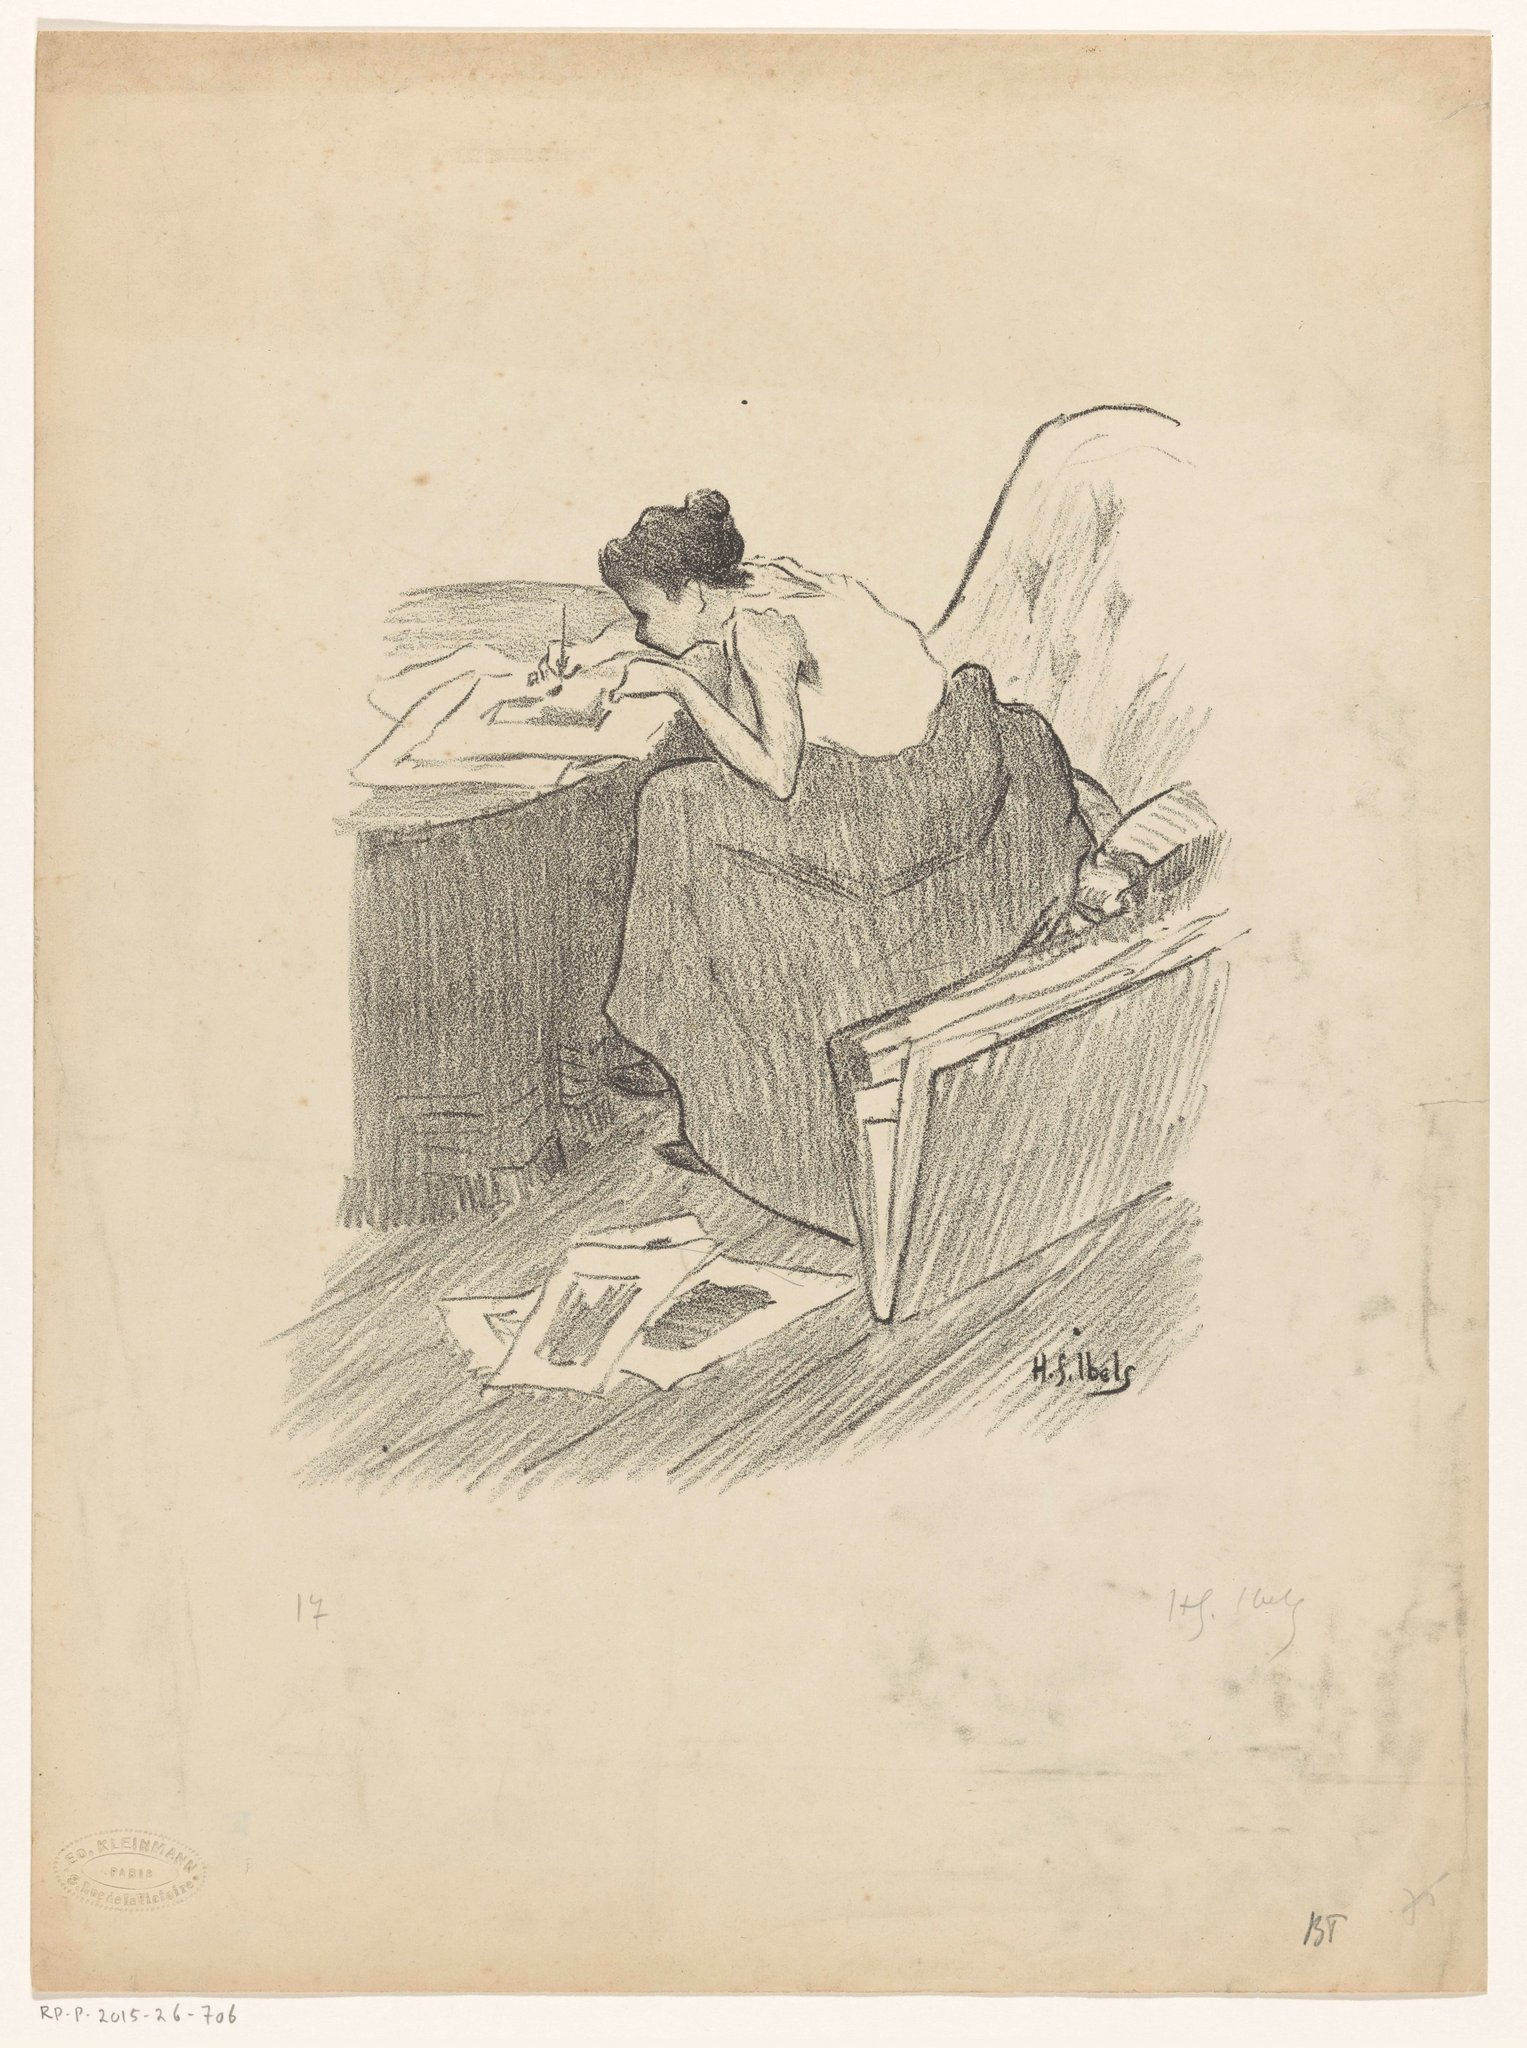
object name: print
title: Vrouw bezig met het inkleuren van prenten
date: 1890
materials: paper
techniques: lithograph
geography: paris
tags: print, e.g.: engraving, etching, lithograph, painting (including book-illumination, miniature-painting)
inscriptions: collector's mark: Lugt 2228, check stamp: Lugt 1573, collector's mark: Lugt 4780, collector's mark: Lugt 4779, signature: ‘H.G. Ibels’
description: Een vrouw op een stoel achter een tafel, bezig met inkleuren van prenten. Naast haar staat een map, op de grond liggen losse prenten.